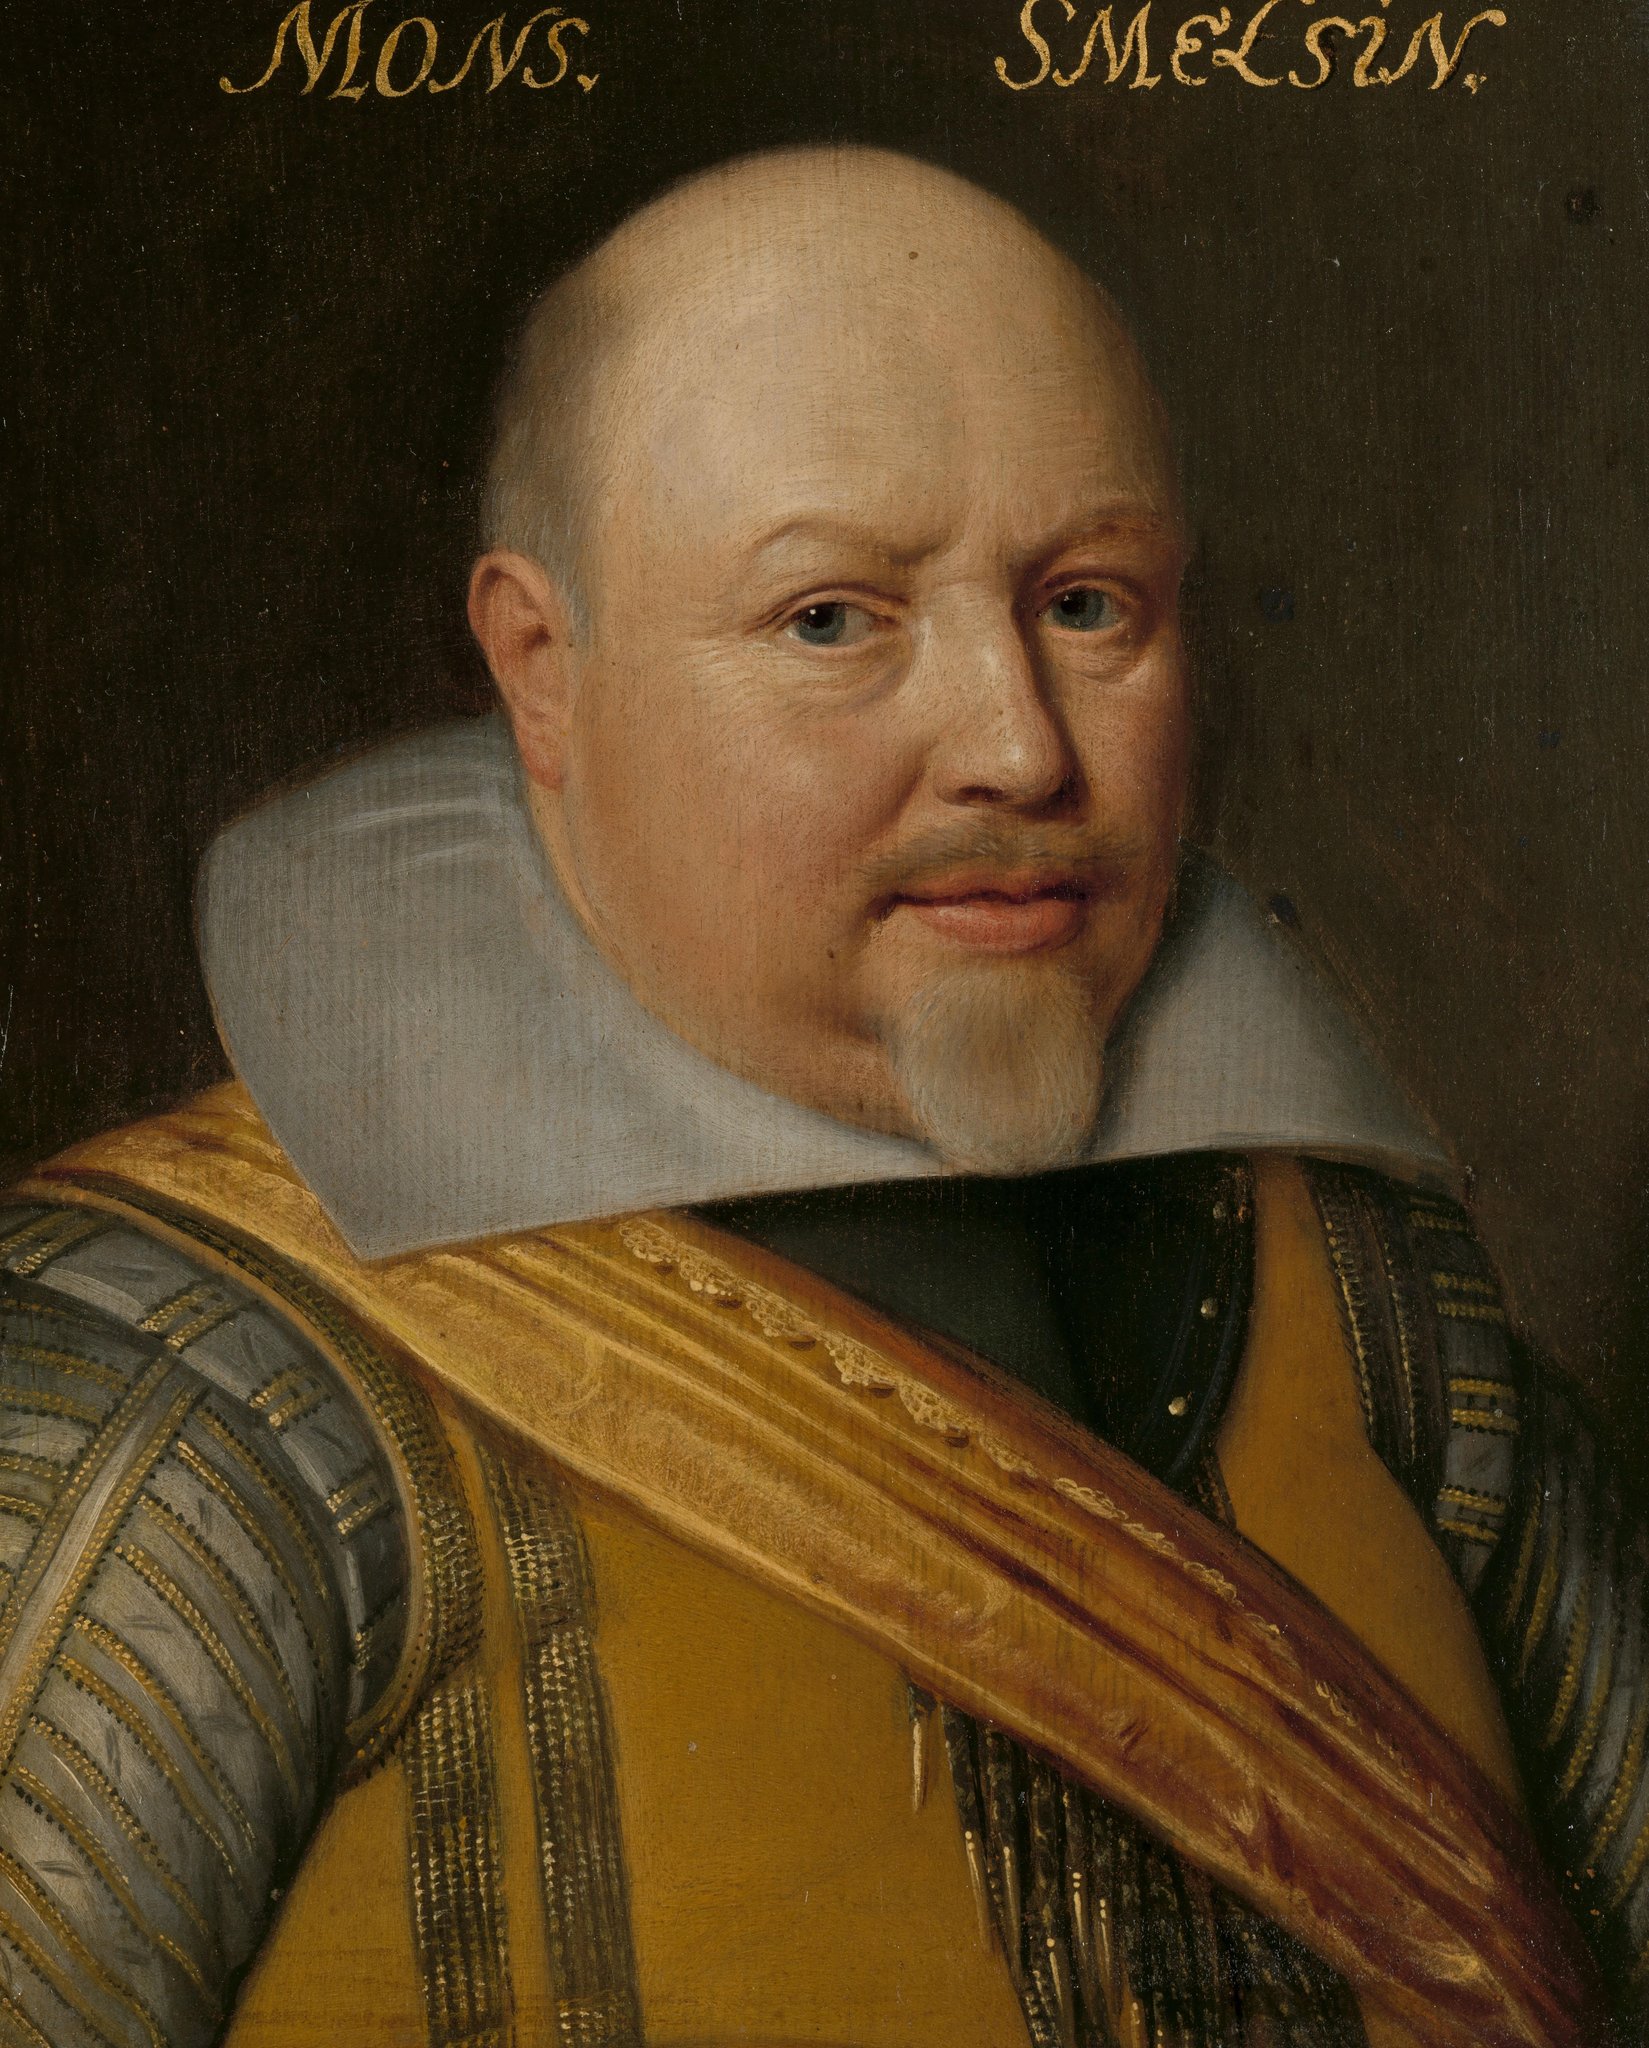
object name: painting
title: Portrait of Nicolaas Schmelzing (1561-1629)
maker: michiel jansz van mierevelt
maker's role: draughtsman, painter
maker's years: 1567-1641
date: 1609-1633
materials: oil, panel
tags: historical persons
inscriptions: inscription, top: ‘MONS. SMELSIN.’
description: Portret van Nicolaas Schmelsingh (1563-1629). Buste naar rechts. Onderdeel van de reeks portretten afkomstig uit het Stadhouderlijk Hof te Leeuwarden.